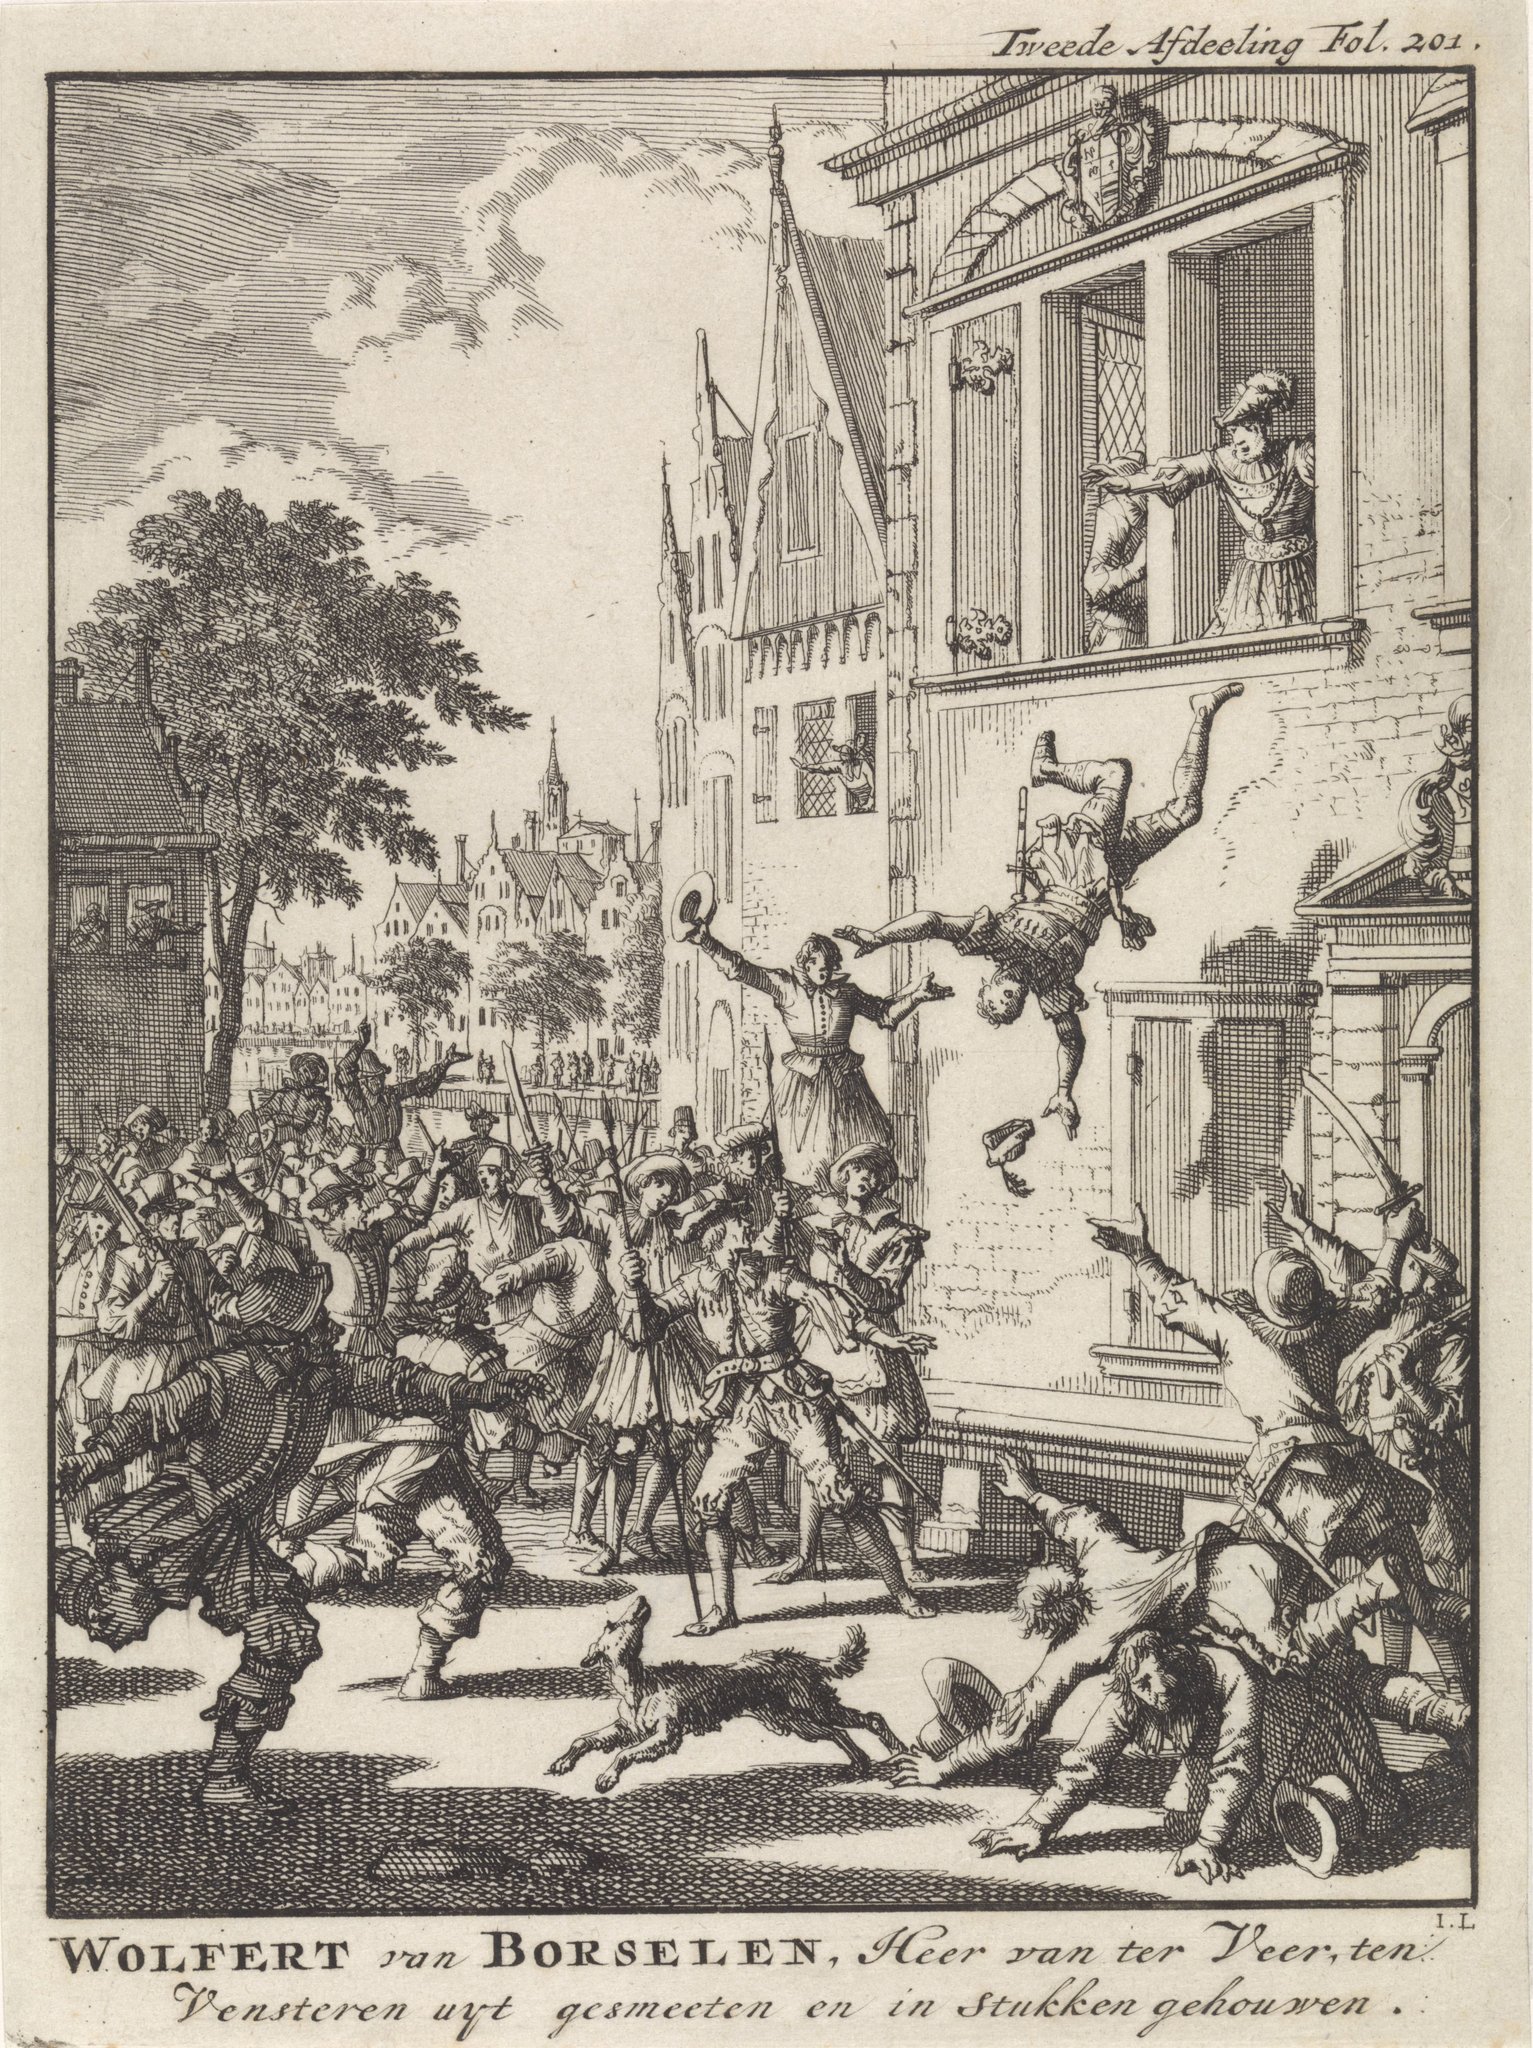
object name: book illustration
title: Wolfert van Borselen te Delft uit het venster geworpen en vermoord, 1299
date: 1698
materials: paper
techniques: engraving, etching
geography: amsterdam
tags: delft, lynching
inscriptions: collector's mark: Lugt 2228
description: Prent ook gebruikt in: Bosch, Lambert van den. Treur-toonneel der doorluchtige mannen, of op- en ondergang der grooten, vertoont in de rampzalige geschiedenissen van (…). 3 delen. Amsterdam: Jan Claesz ten Hoorn, 1698, dl. 1, afd. 2, tussen p. 200 en 201.